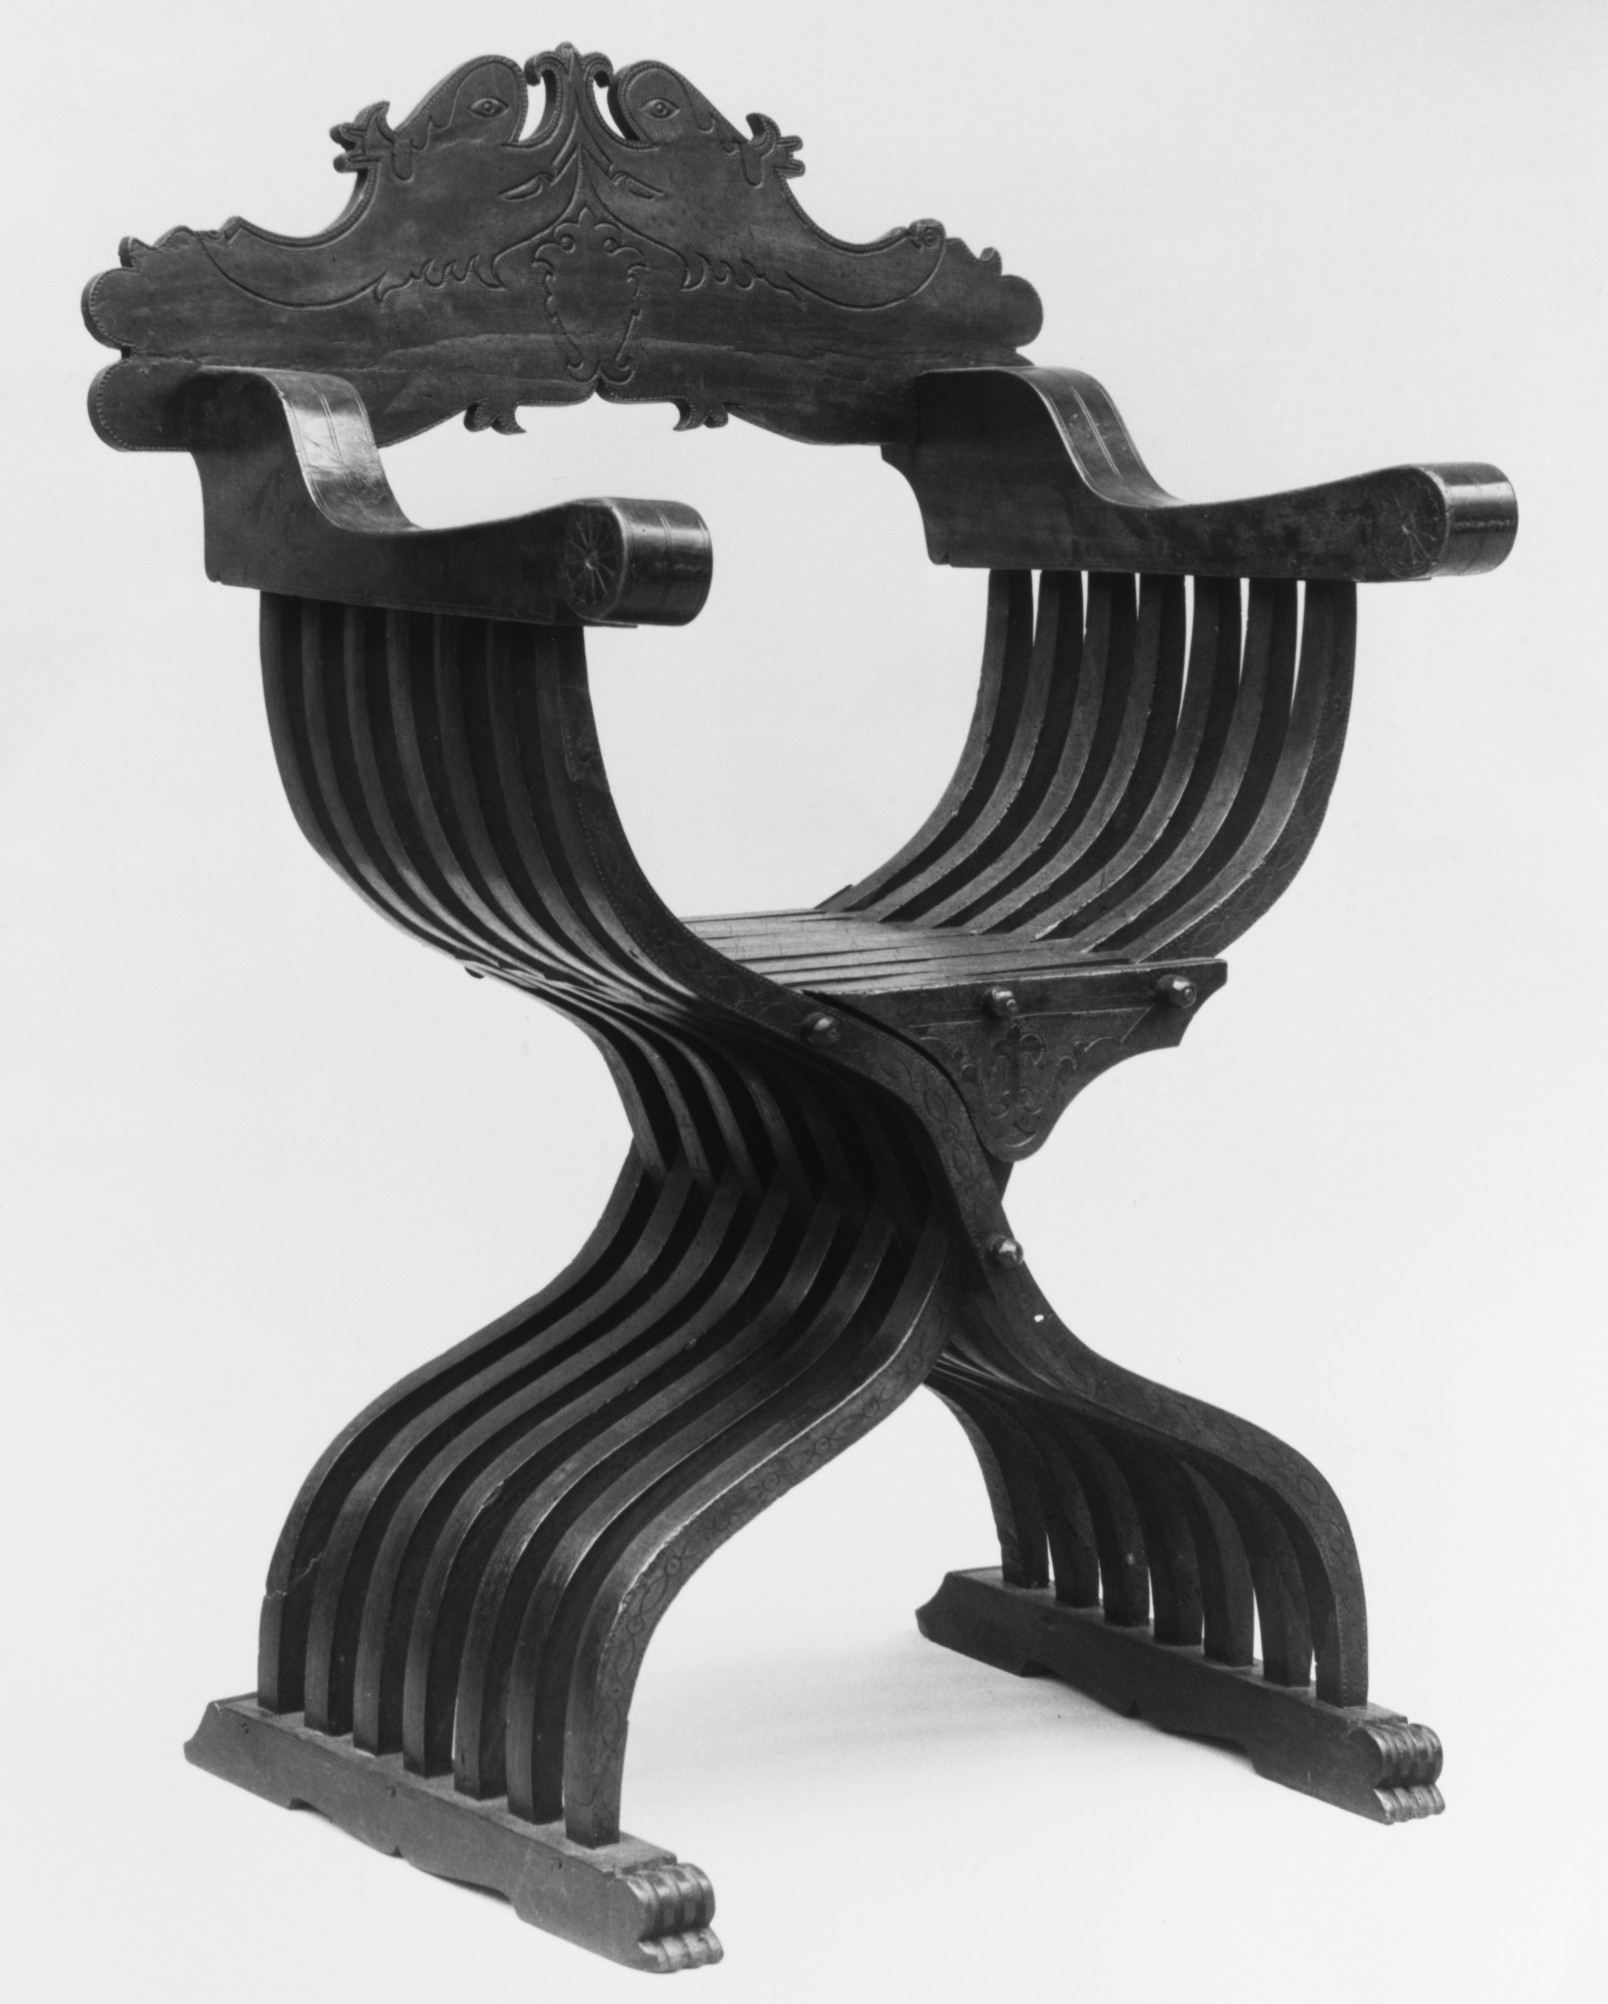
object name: armchair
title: Folding armchair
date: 1501-1600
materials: wood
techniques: carving